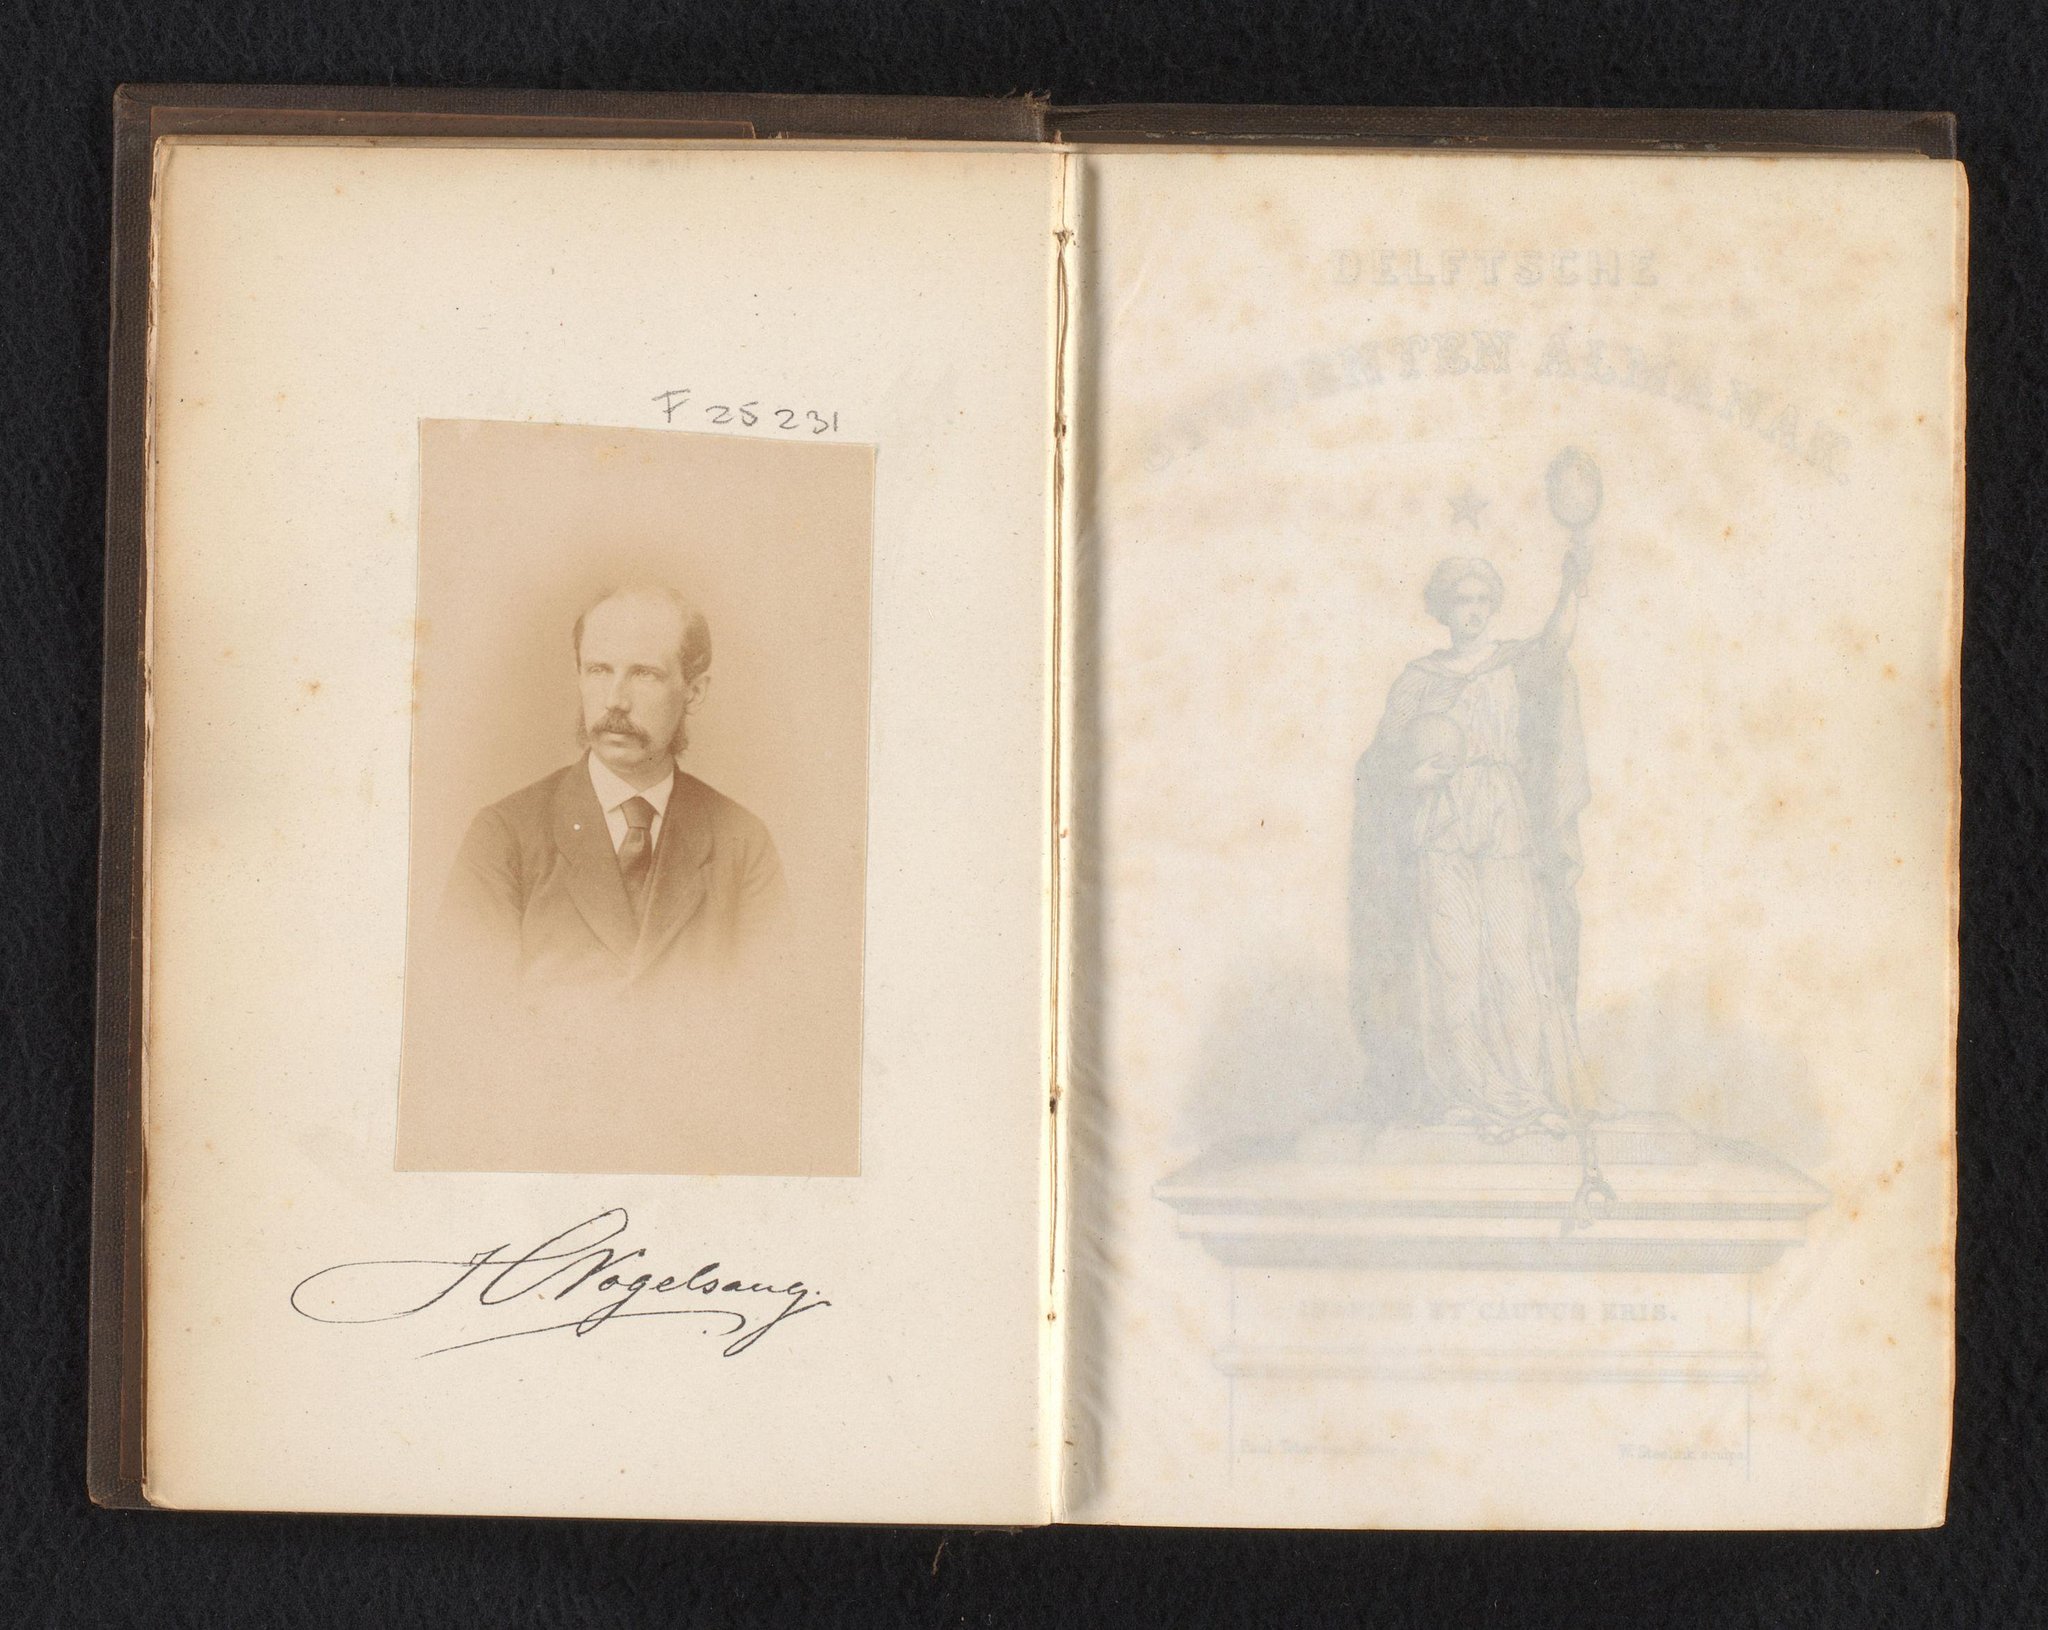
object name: photograph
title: Portret van Hermann Vogelsang, hoogleraar mijnbouwkunde aan de Polytechnische School Delft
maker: Anonymous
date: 1872-1873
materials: paper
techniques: albumen print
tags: historical persons, professor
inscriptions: signature: ‘H. Vogelsang’